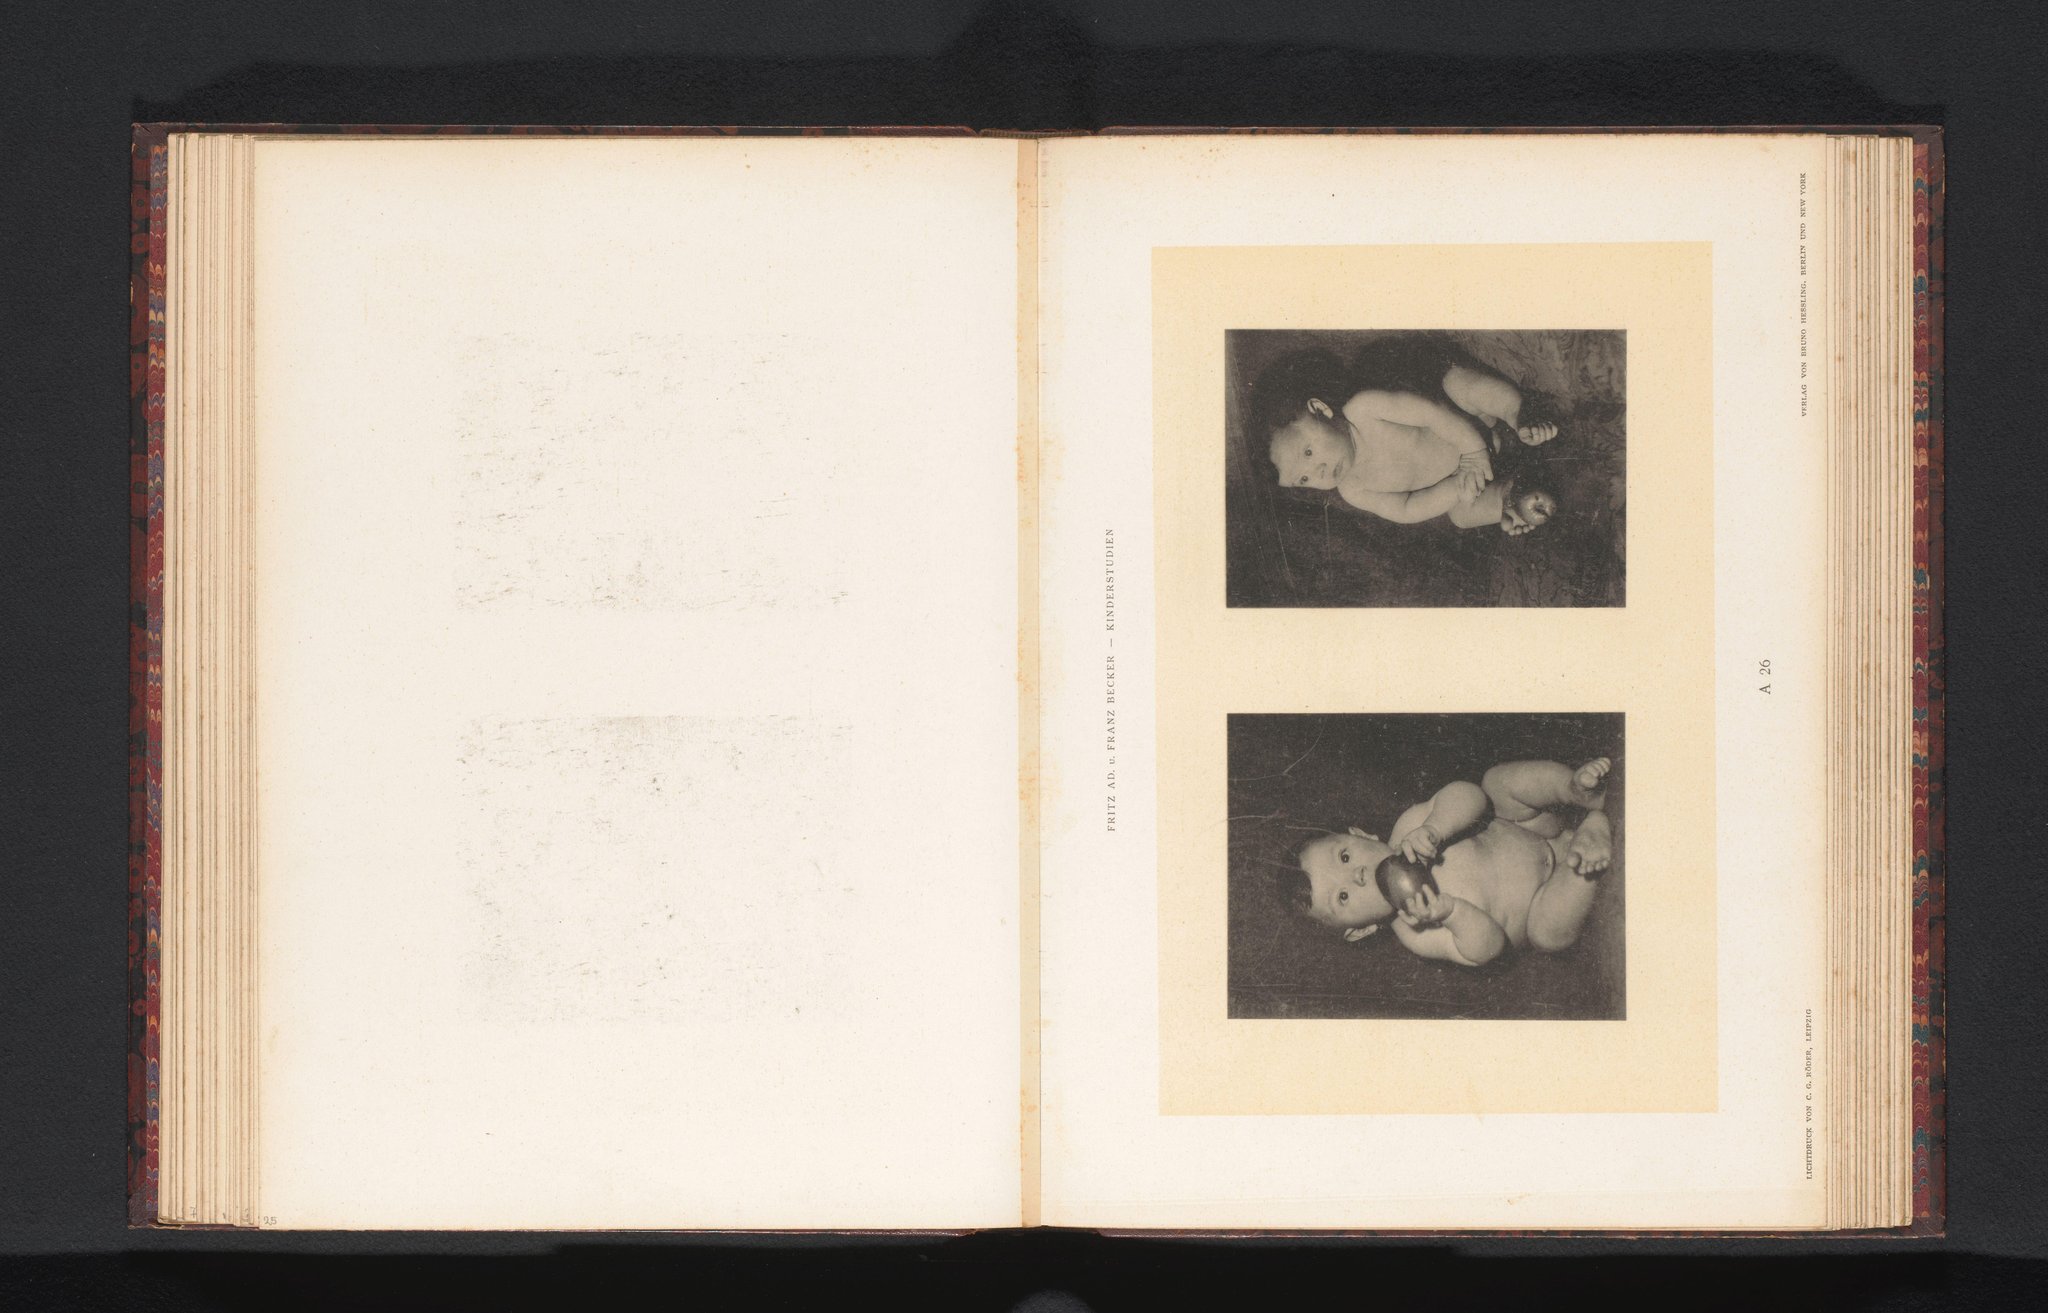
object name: photomechanical print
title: Twee afbeeldingen van een zittende naakte jongen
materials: paper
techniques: photograph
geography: leipzig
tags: sitting figure, toddler (male)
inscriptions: number: ‘A 26’